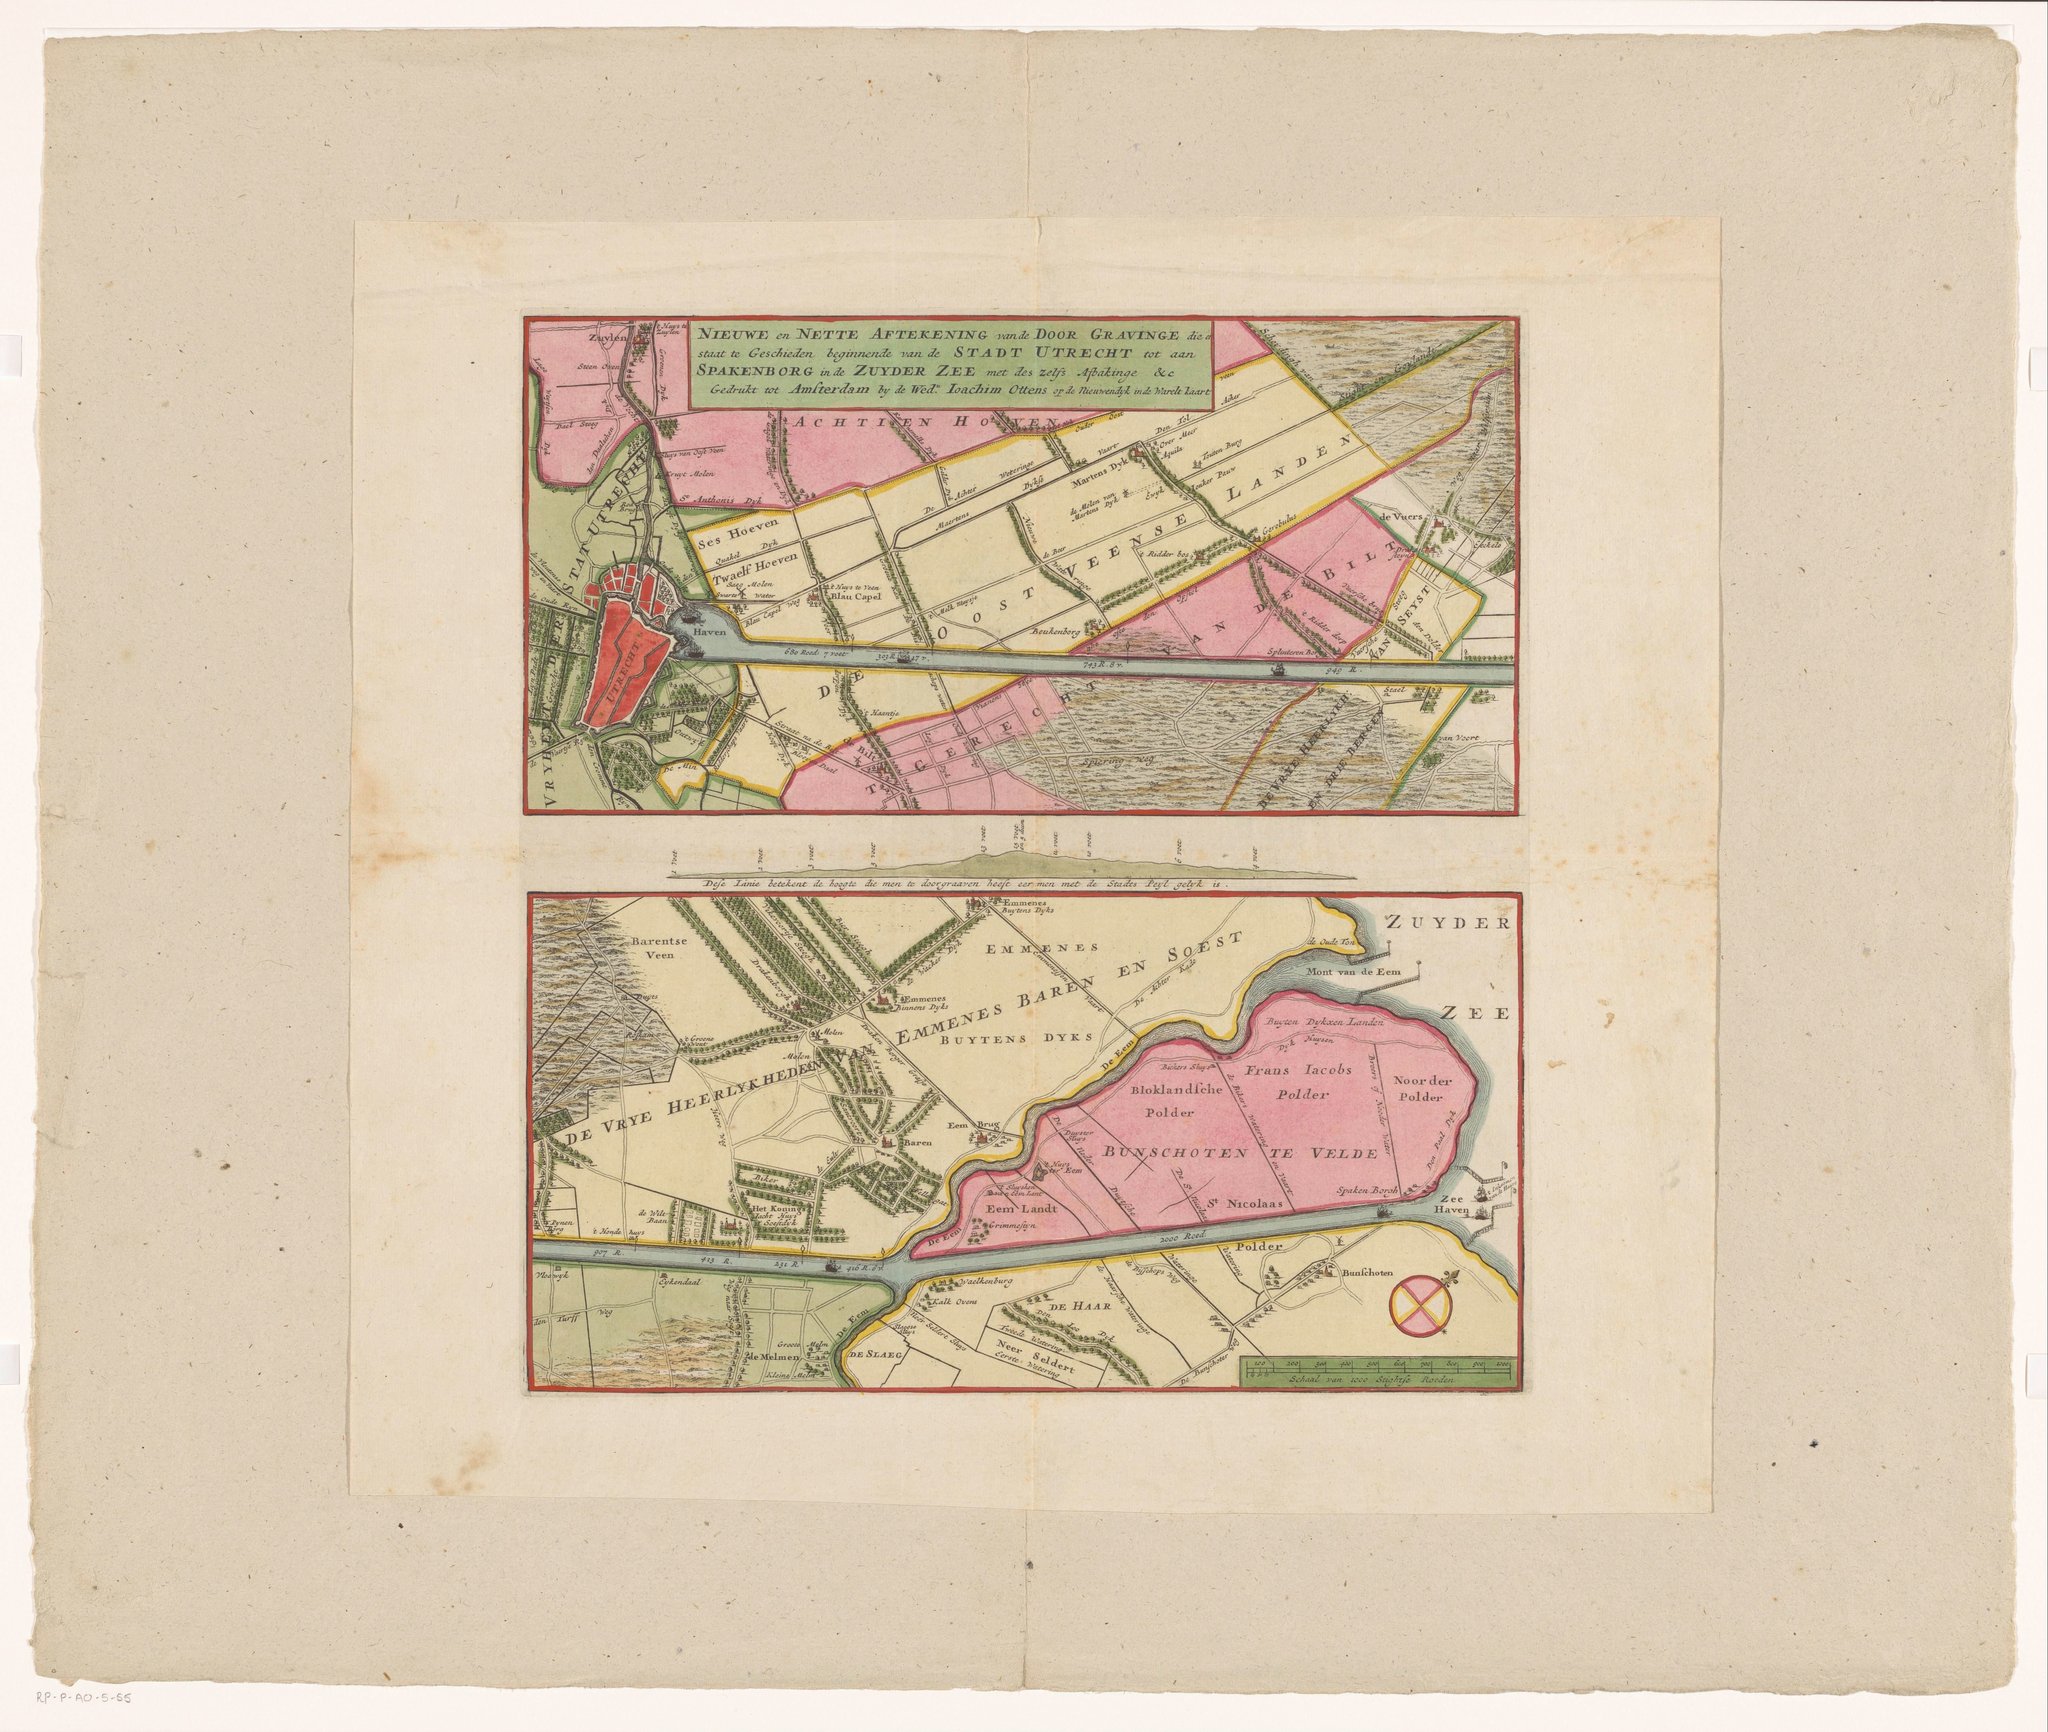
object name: map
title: Kaart van het voorgestelde kanaal tussen Utrecht en de Zuiderzee, 1720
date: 1720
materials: paper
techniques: engraving, etching, hand coloring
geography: amsterdam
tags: financial panic, maps of separate countries or regions, utrecht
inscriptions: collector's mark: Lugt 19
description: Kaart in twee delen van het voorgestelde kanaal te graven tussen Utrecht en de Zuiderzee. Voor dit project werd in 1720 geld ingezameld. Rechtsonder een schaalstok: Schaal van 1000 Stightse roeden. Prent 6 in de serie Het Groote Tafereel der Dwaasheid met spotprenten op de Windhandel of Actiehandel van 1720.